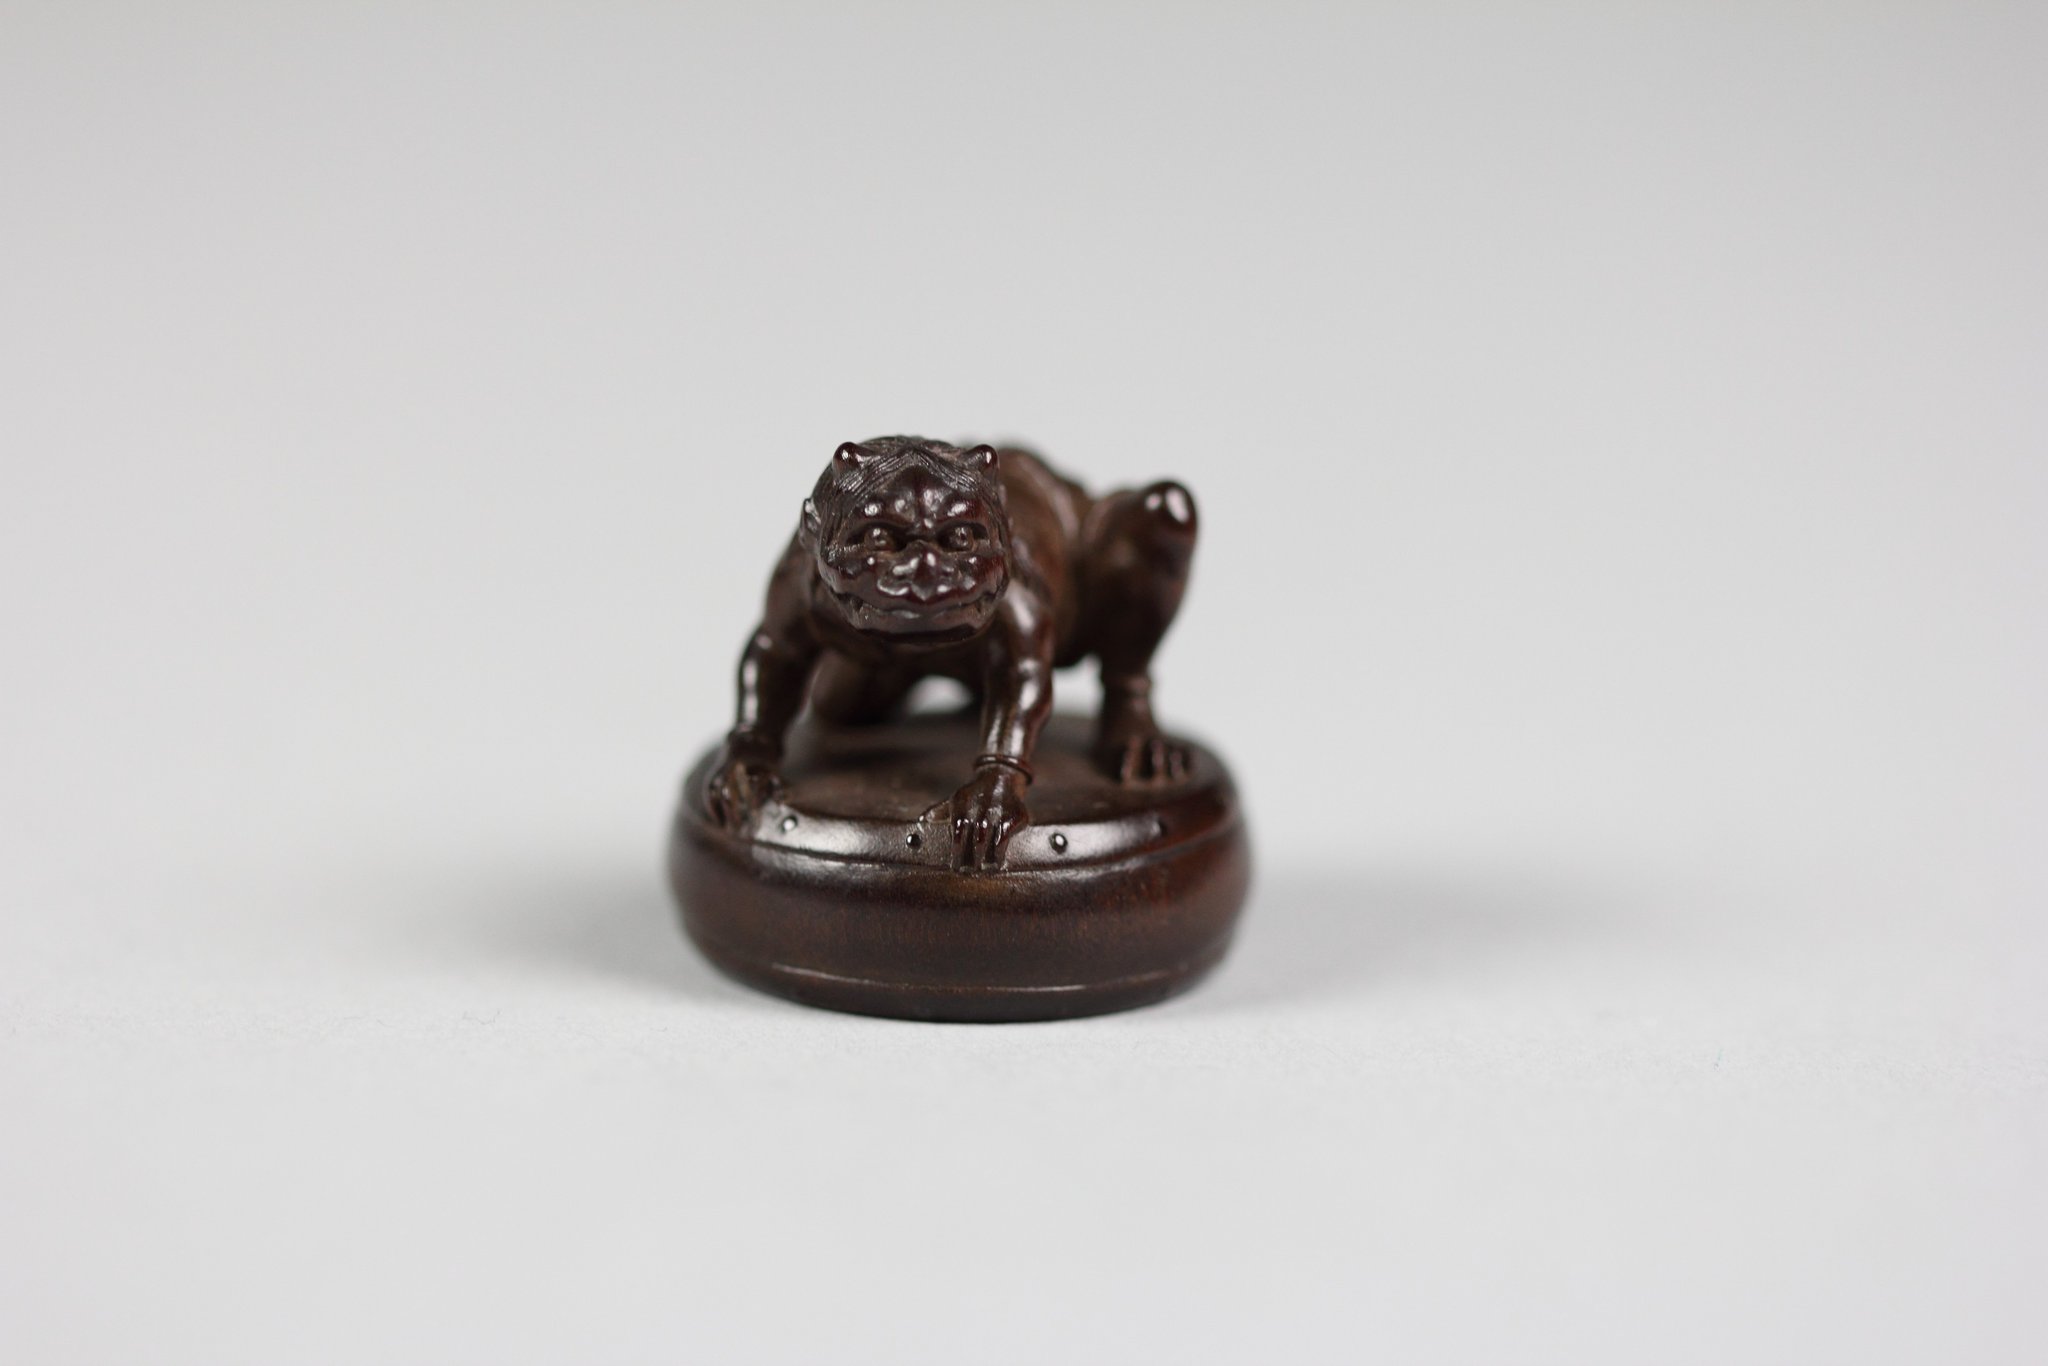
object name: netsuke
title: Netsuke of Demon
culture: japanese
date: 1801-1900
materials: wood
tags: demons